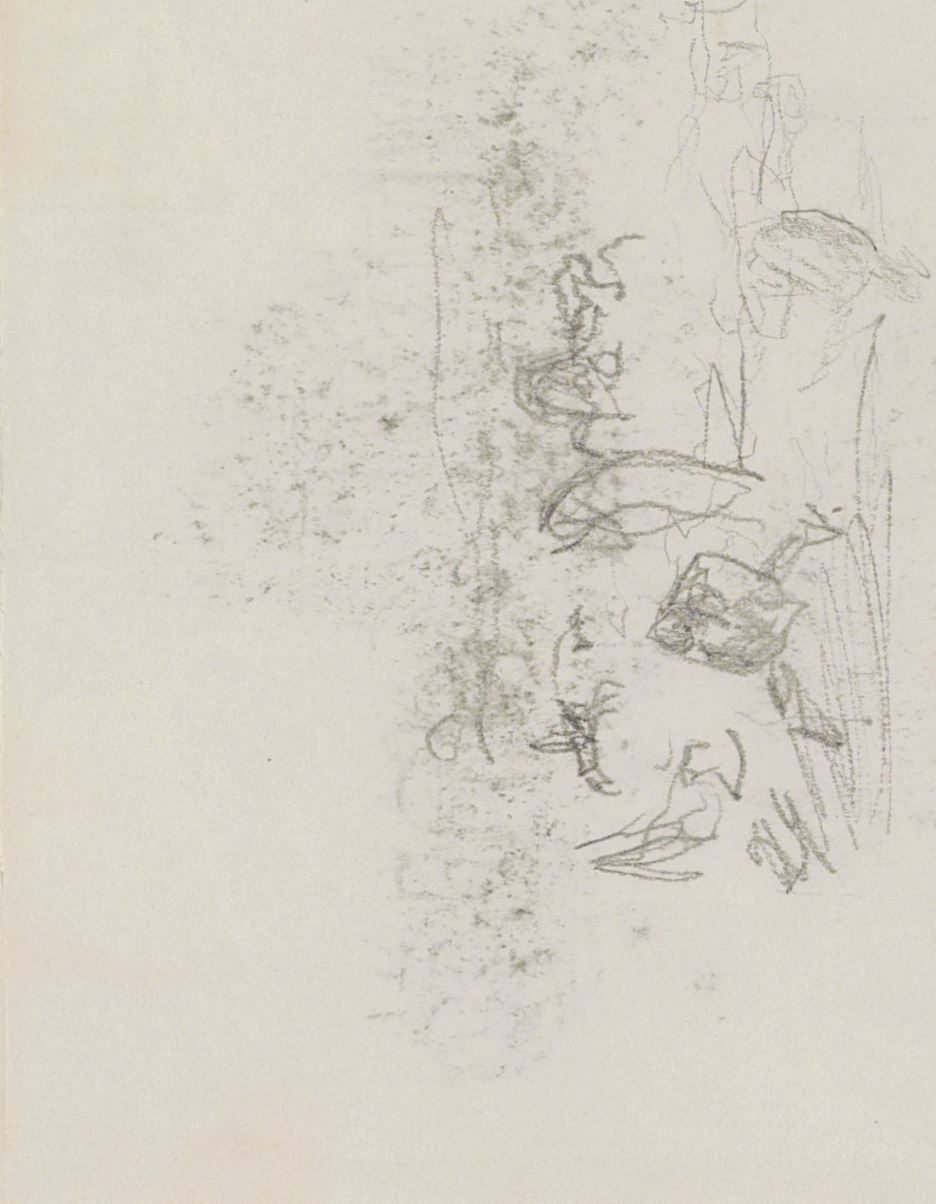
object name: sketchbook leaf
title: Studie, mogelijk van zittende figuren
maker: marius bauer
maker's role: draughtsman, print maker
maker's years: 1867-1932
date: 1924-1925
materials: paper, pencil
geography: india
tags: sitting figure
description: Achterste schutblad uit een schetsboek met 75 bladen.